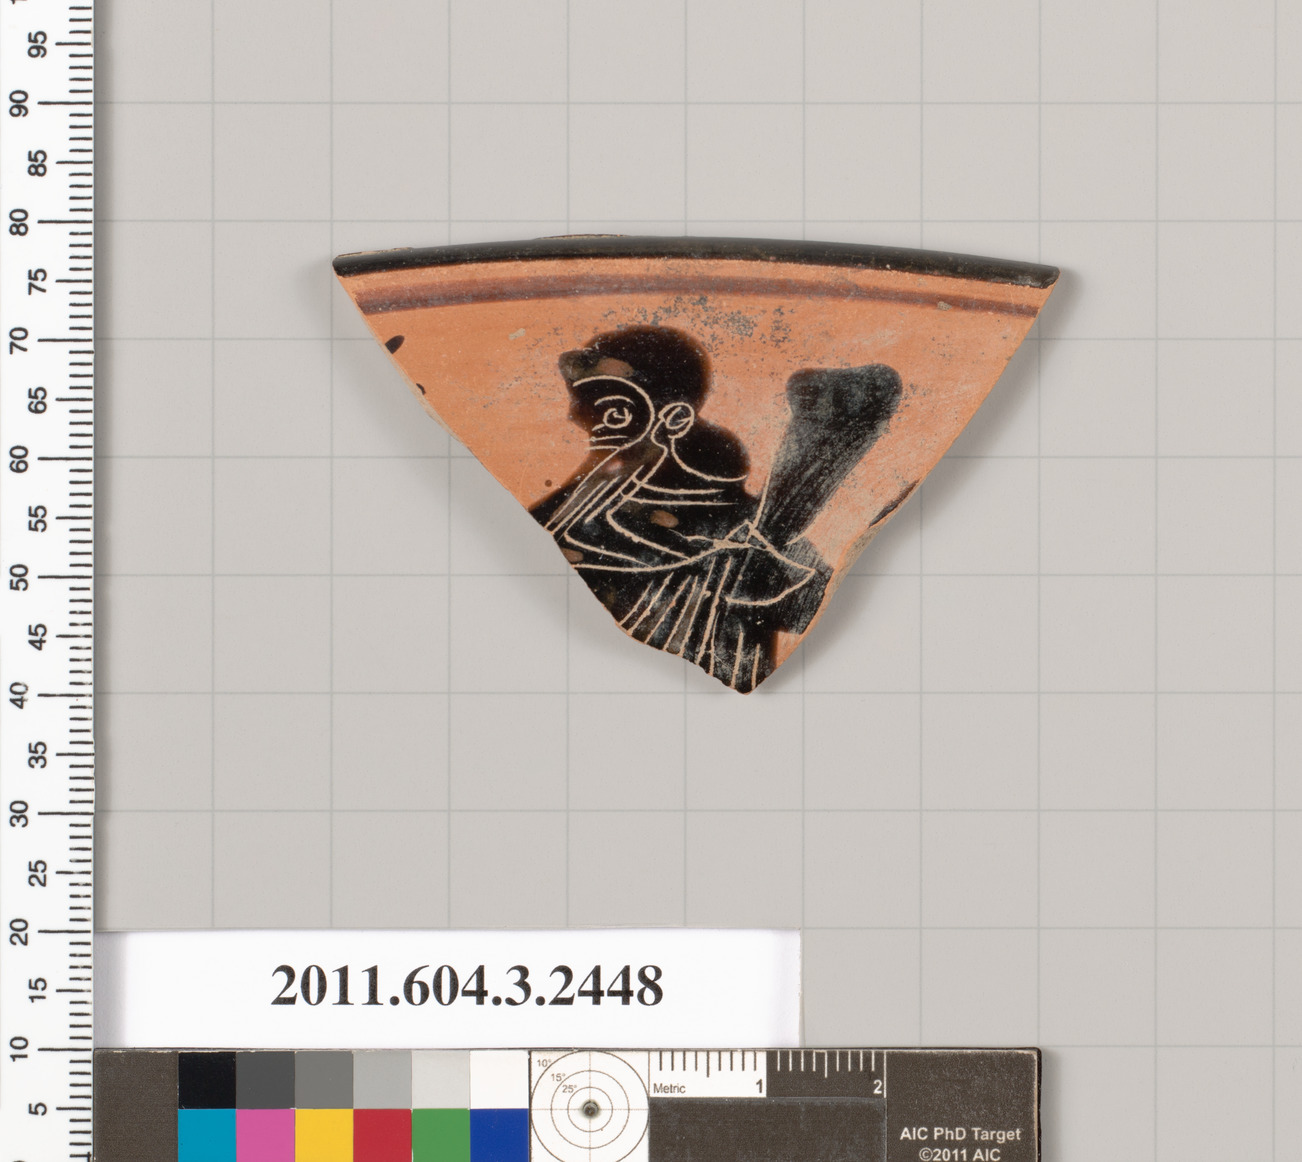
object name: kylix fragment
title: Terracotta rim fragment of a kylix (drinking cup)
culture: greek, attic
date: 525-501 BCE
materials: terracotta